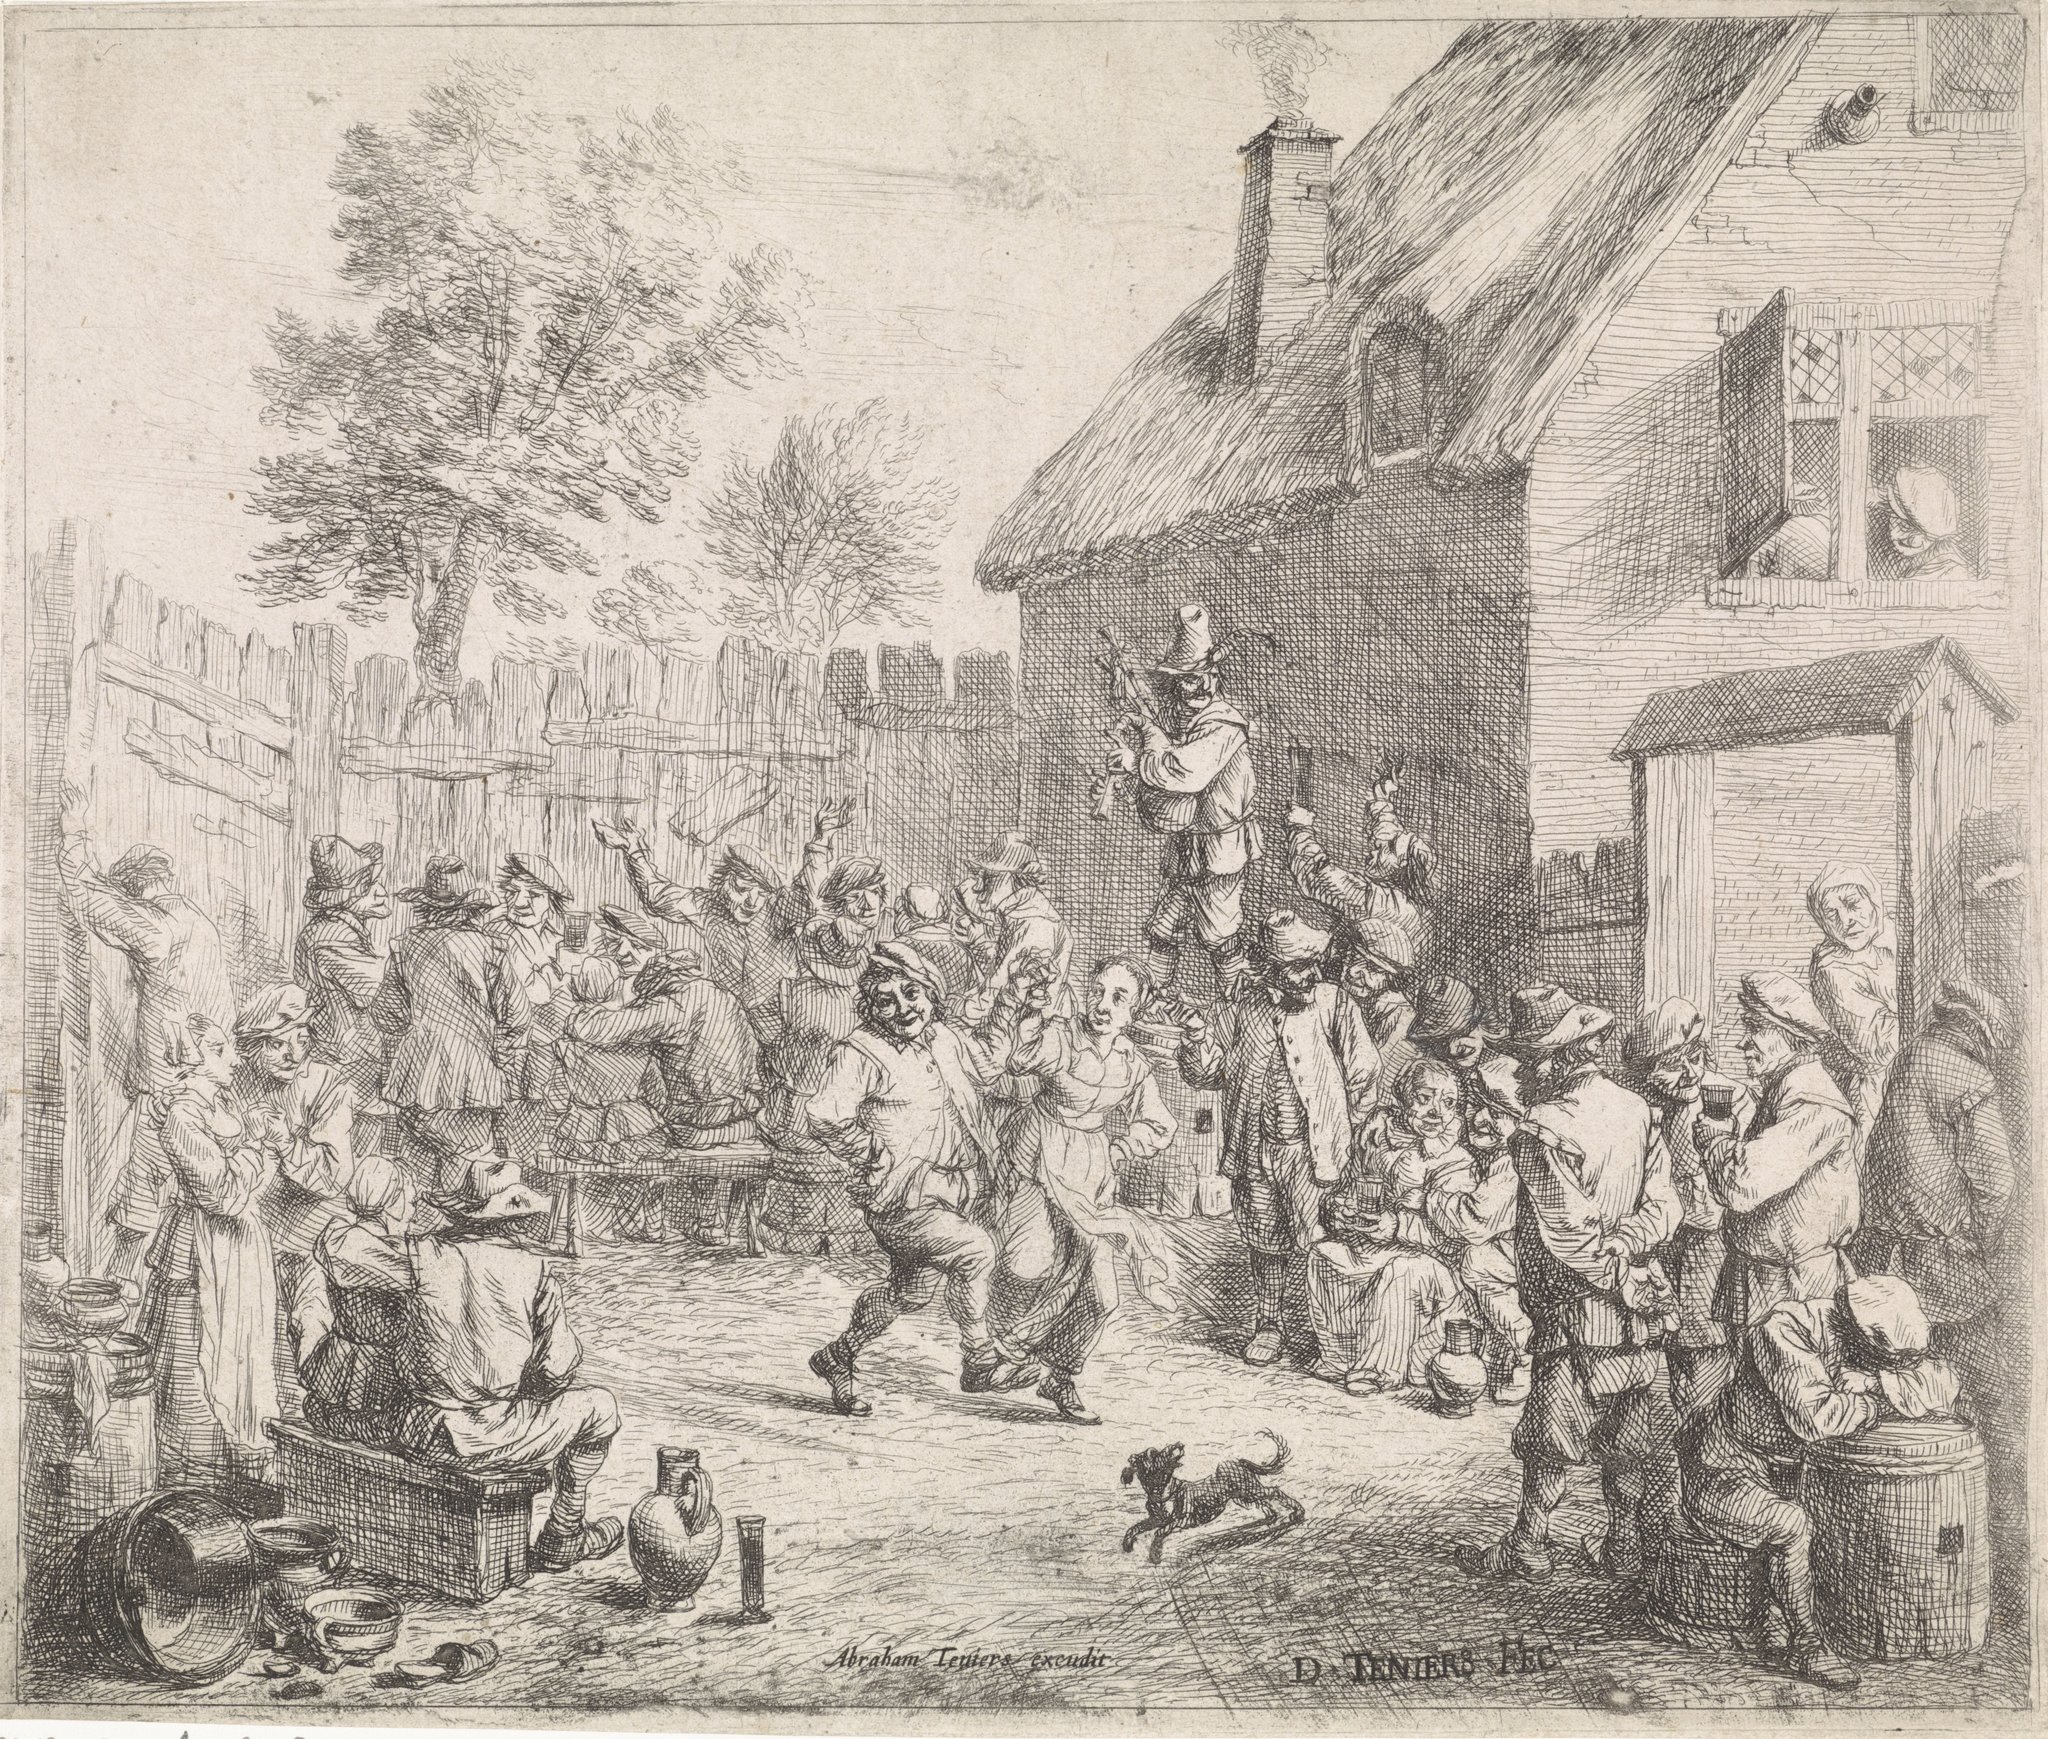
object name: print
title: Boerenkermis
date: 1639-1690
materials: paper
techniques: etching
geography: antwerp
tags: inn, coffee-house, public house, etc., one pair dancing; man and woman dancing as a couple, farmers, bagpipe, musette - cc - out of doors, drinking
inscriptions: collector's mark: Lugt 2228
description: Een groep drinkende boeren naast een herberg. Een paar danst op de muziek van een doedelzakspeler.